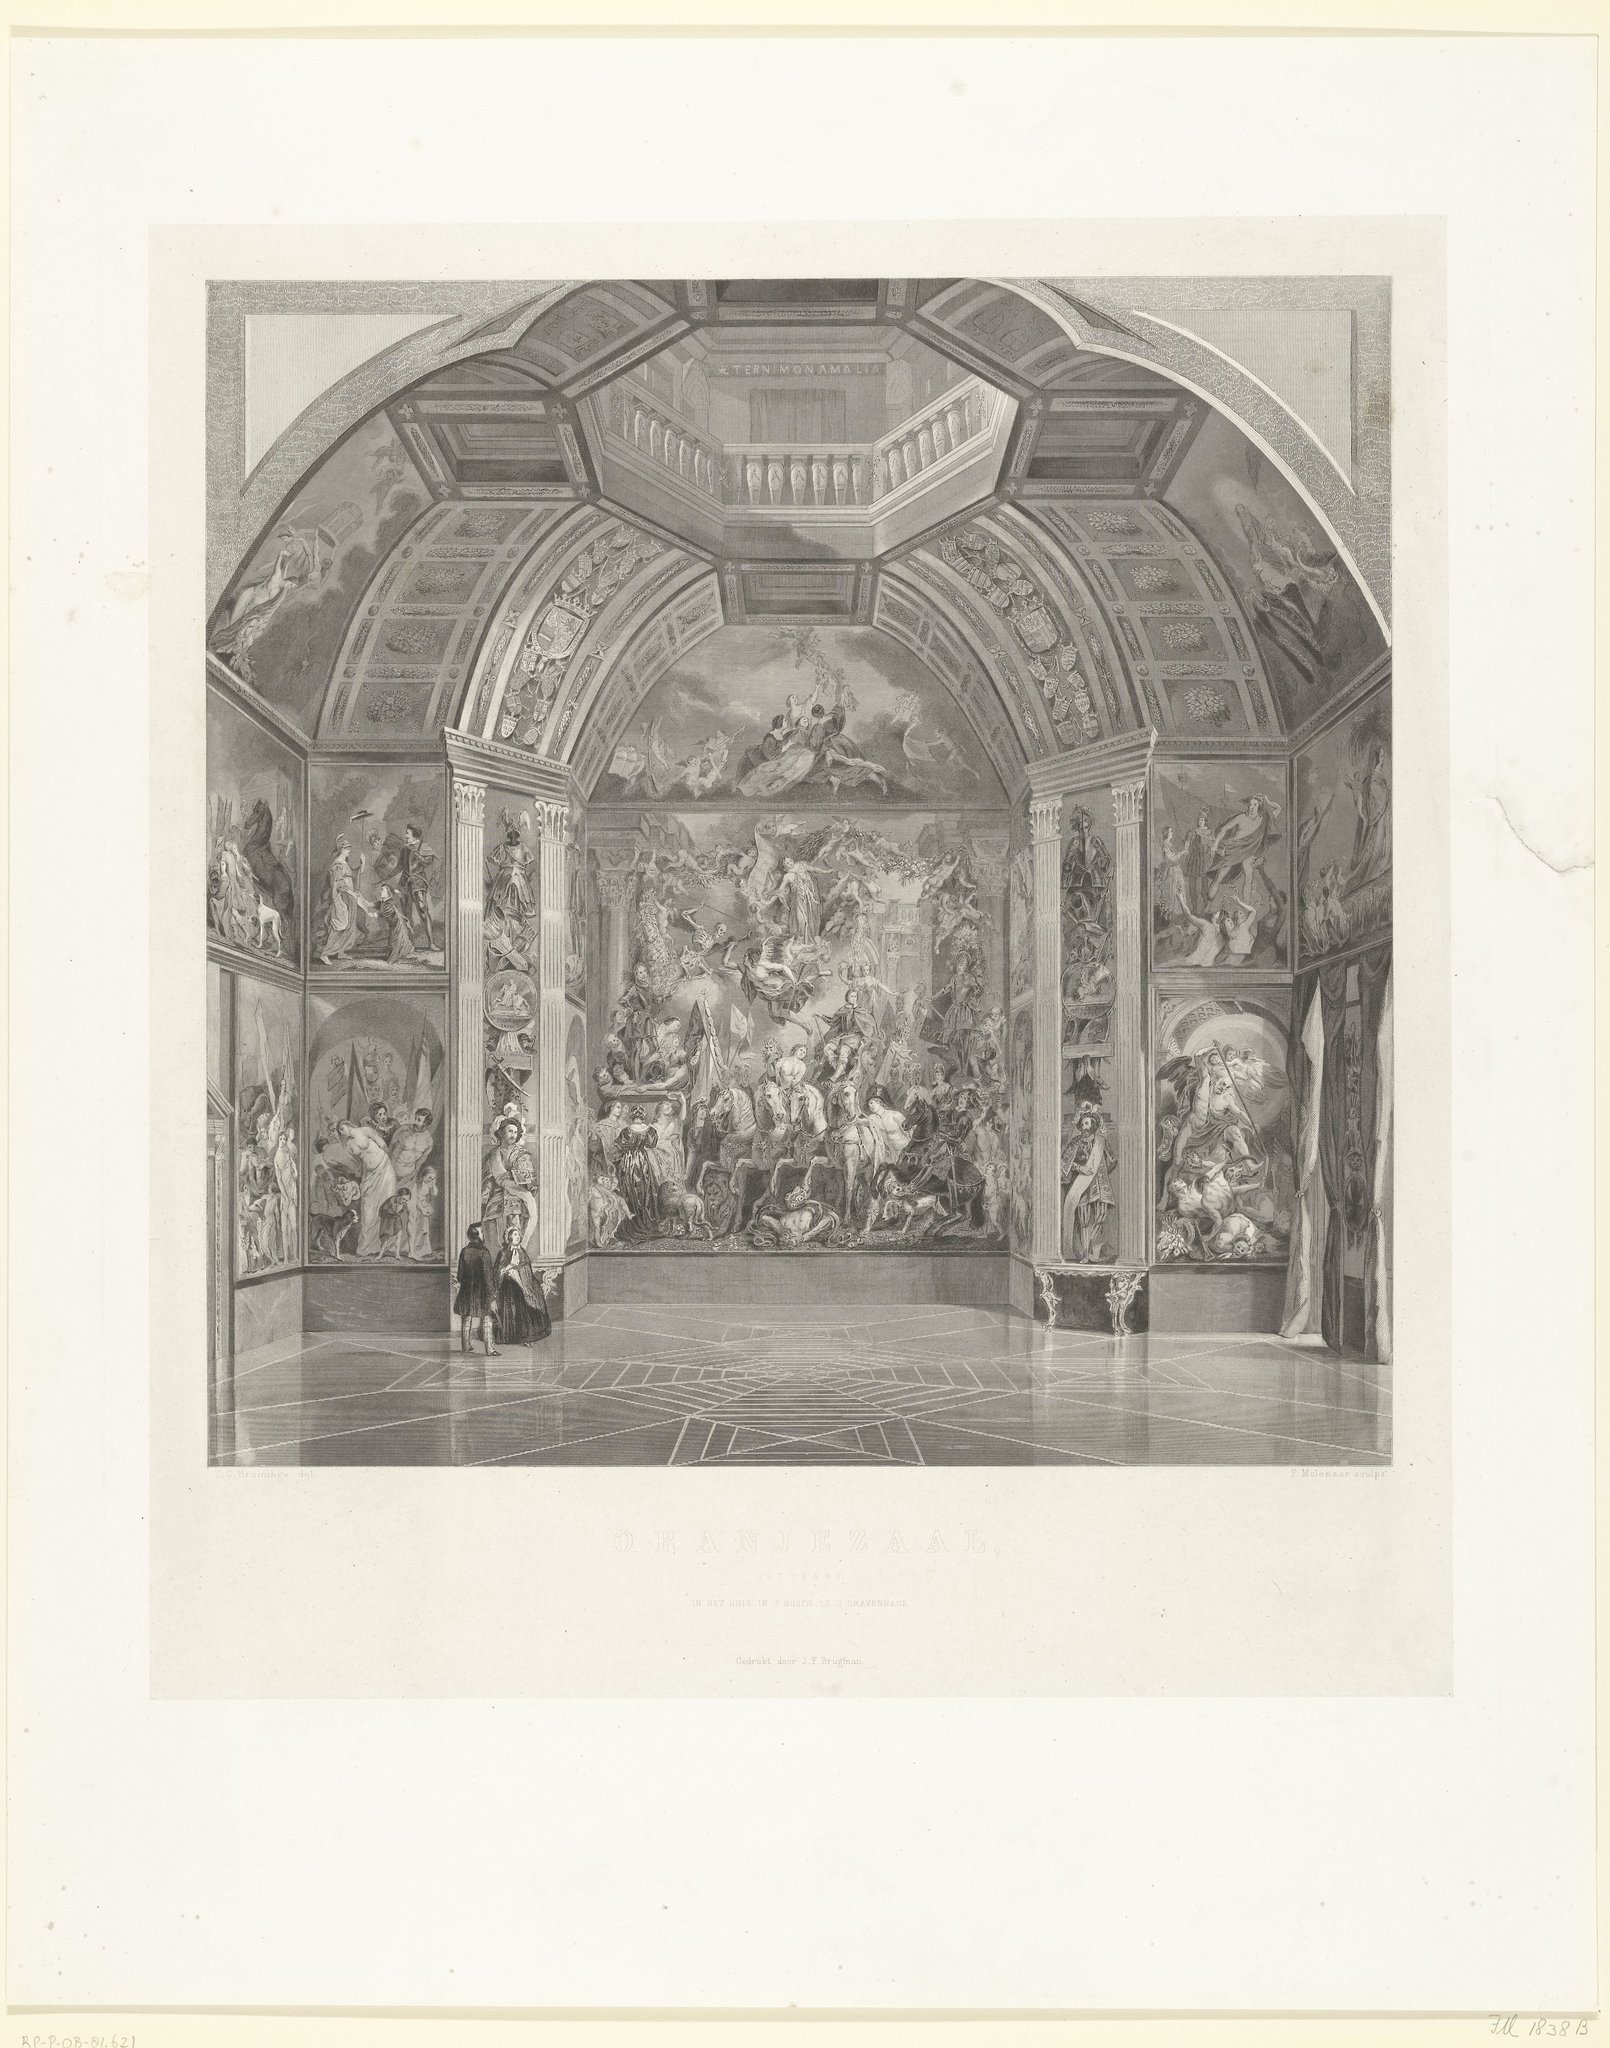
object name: print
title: Oranjezaal. oostkant in het Huis in 't Bosch te 's-Gravenhage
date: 1850-1880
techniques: printmaking, engraving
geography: netherlands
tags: delft, the hague, frederick henry (prince of orange), palace, picture, painting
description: Gezicht in de Oranjezaal van het paleis Huis ten Bosch te 's-Gravenhage, ca. 1875. De centrale voorstelling van stadhouder Frederik Hendrik in zijn triomfwagen getrokken door vier witte paarden en bekroond door Overwinning en Overvloed, voltooid in 1652. Links enkele bezoekers.